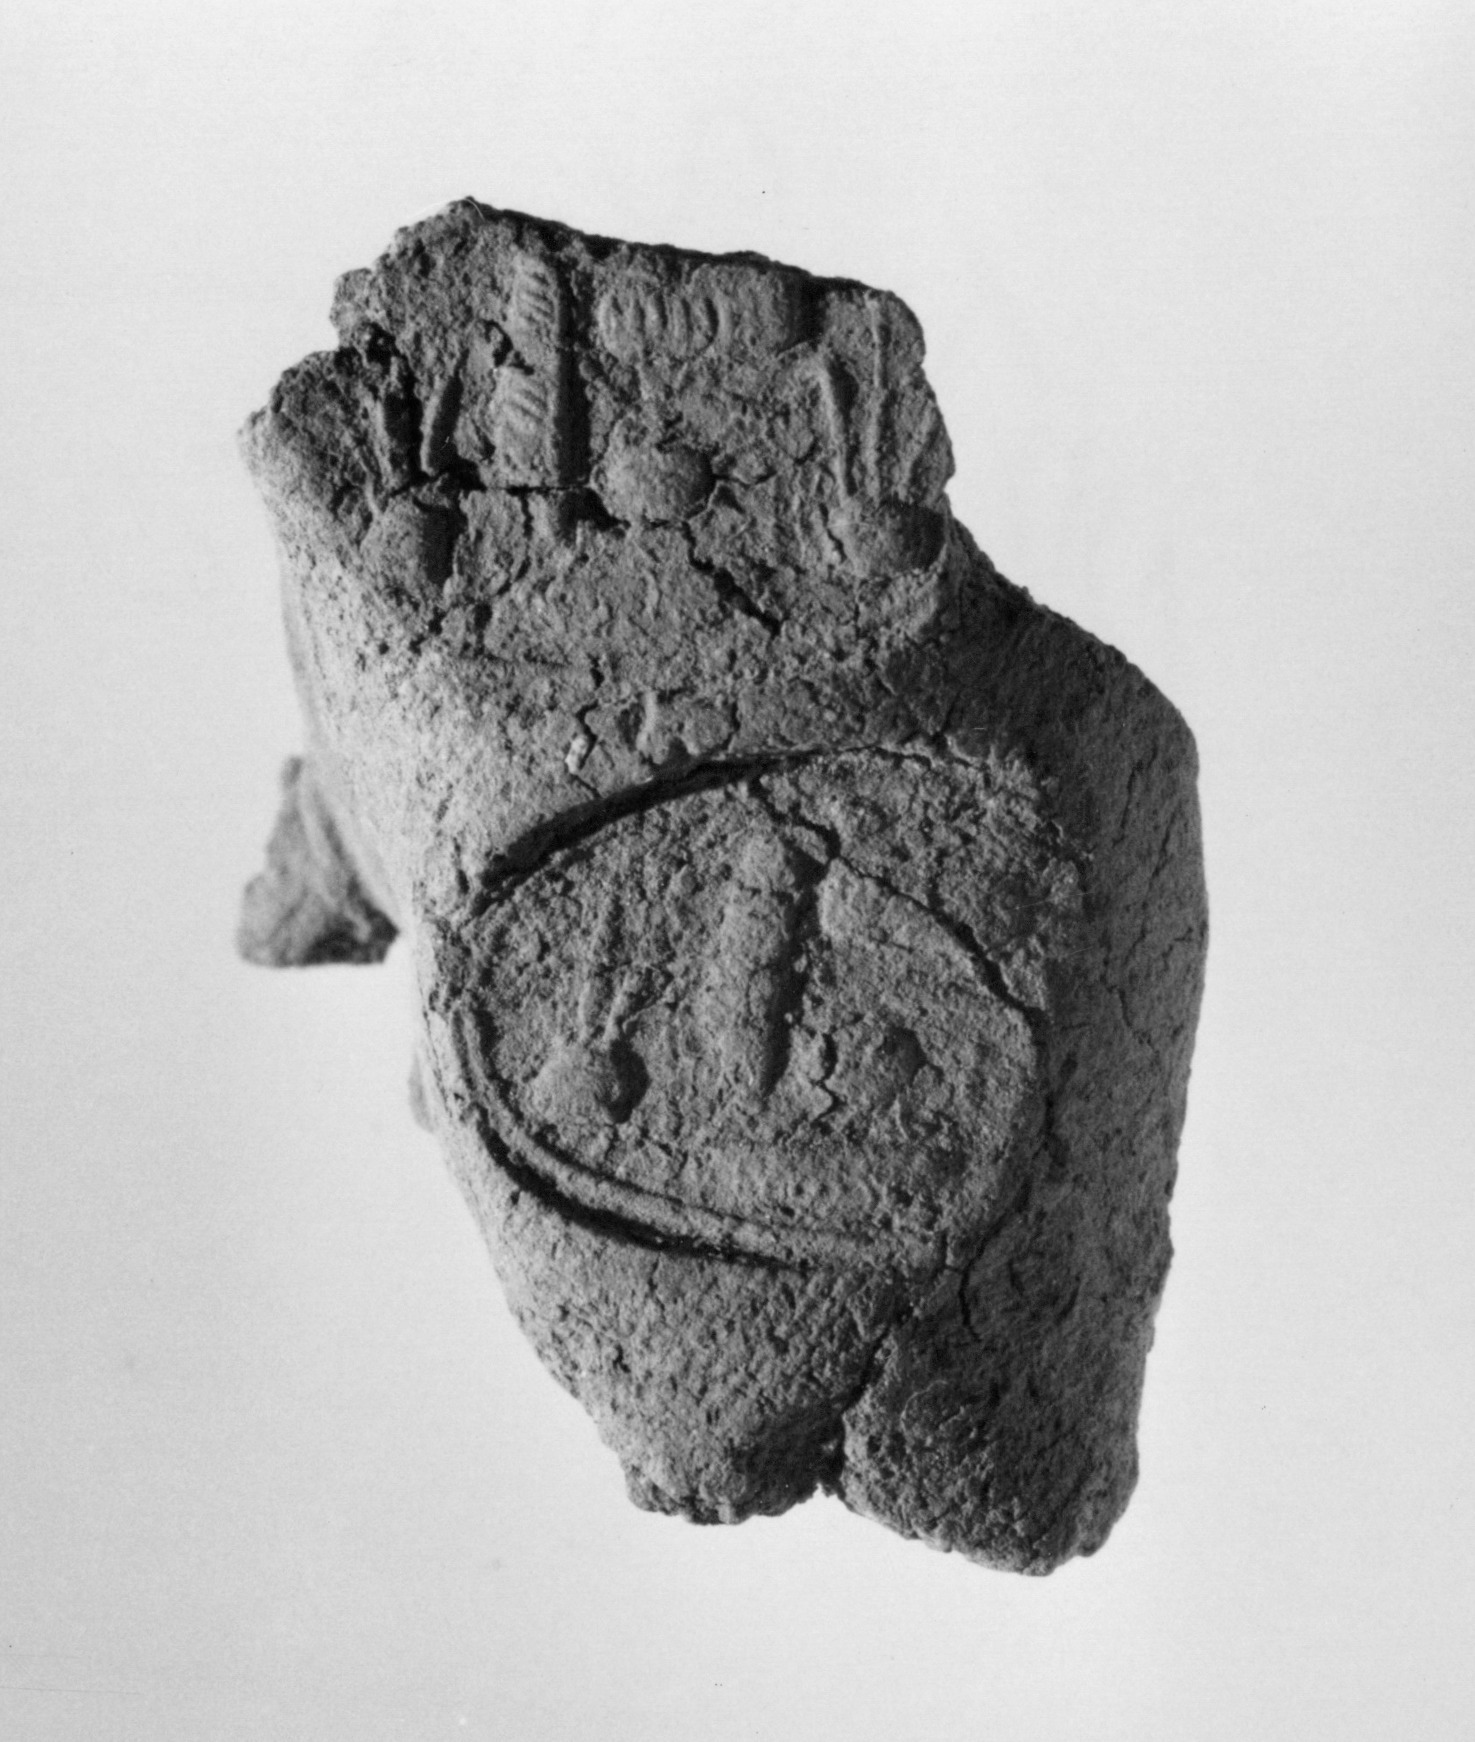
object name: sealing, amun re, upper egypt, lower egypt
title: Document Sealing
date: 1390-1352 BCE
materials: mud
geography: egypt